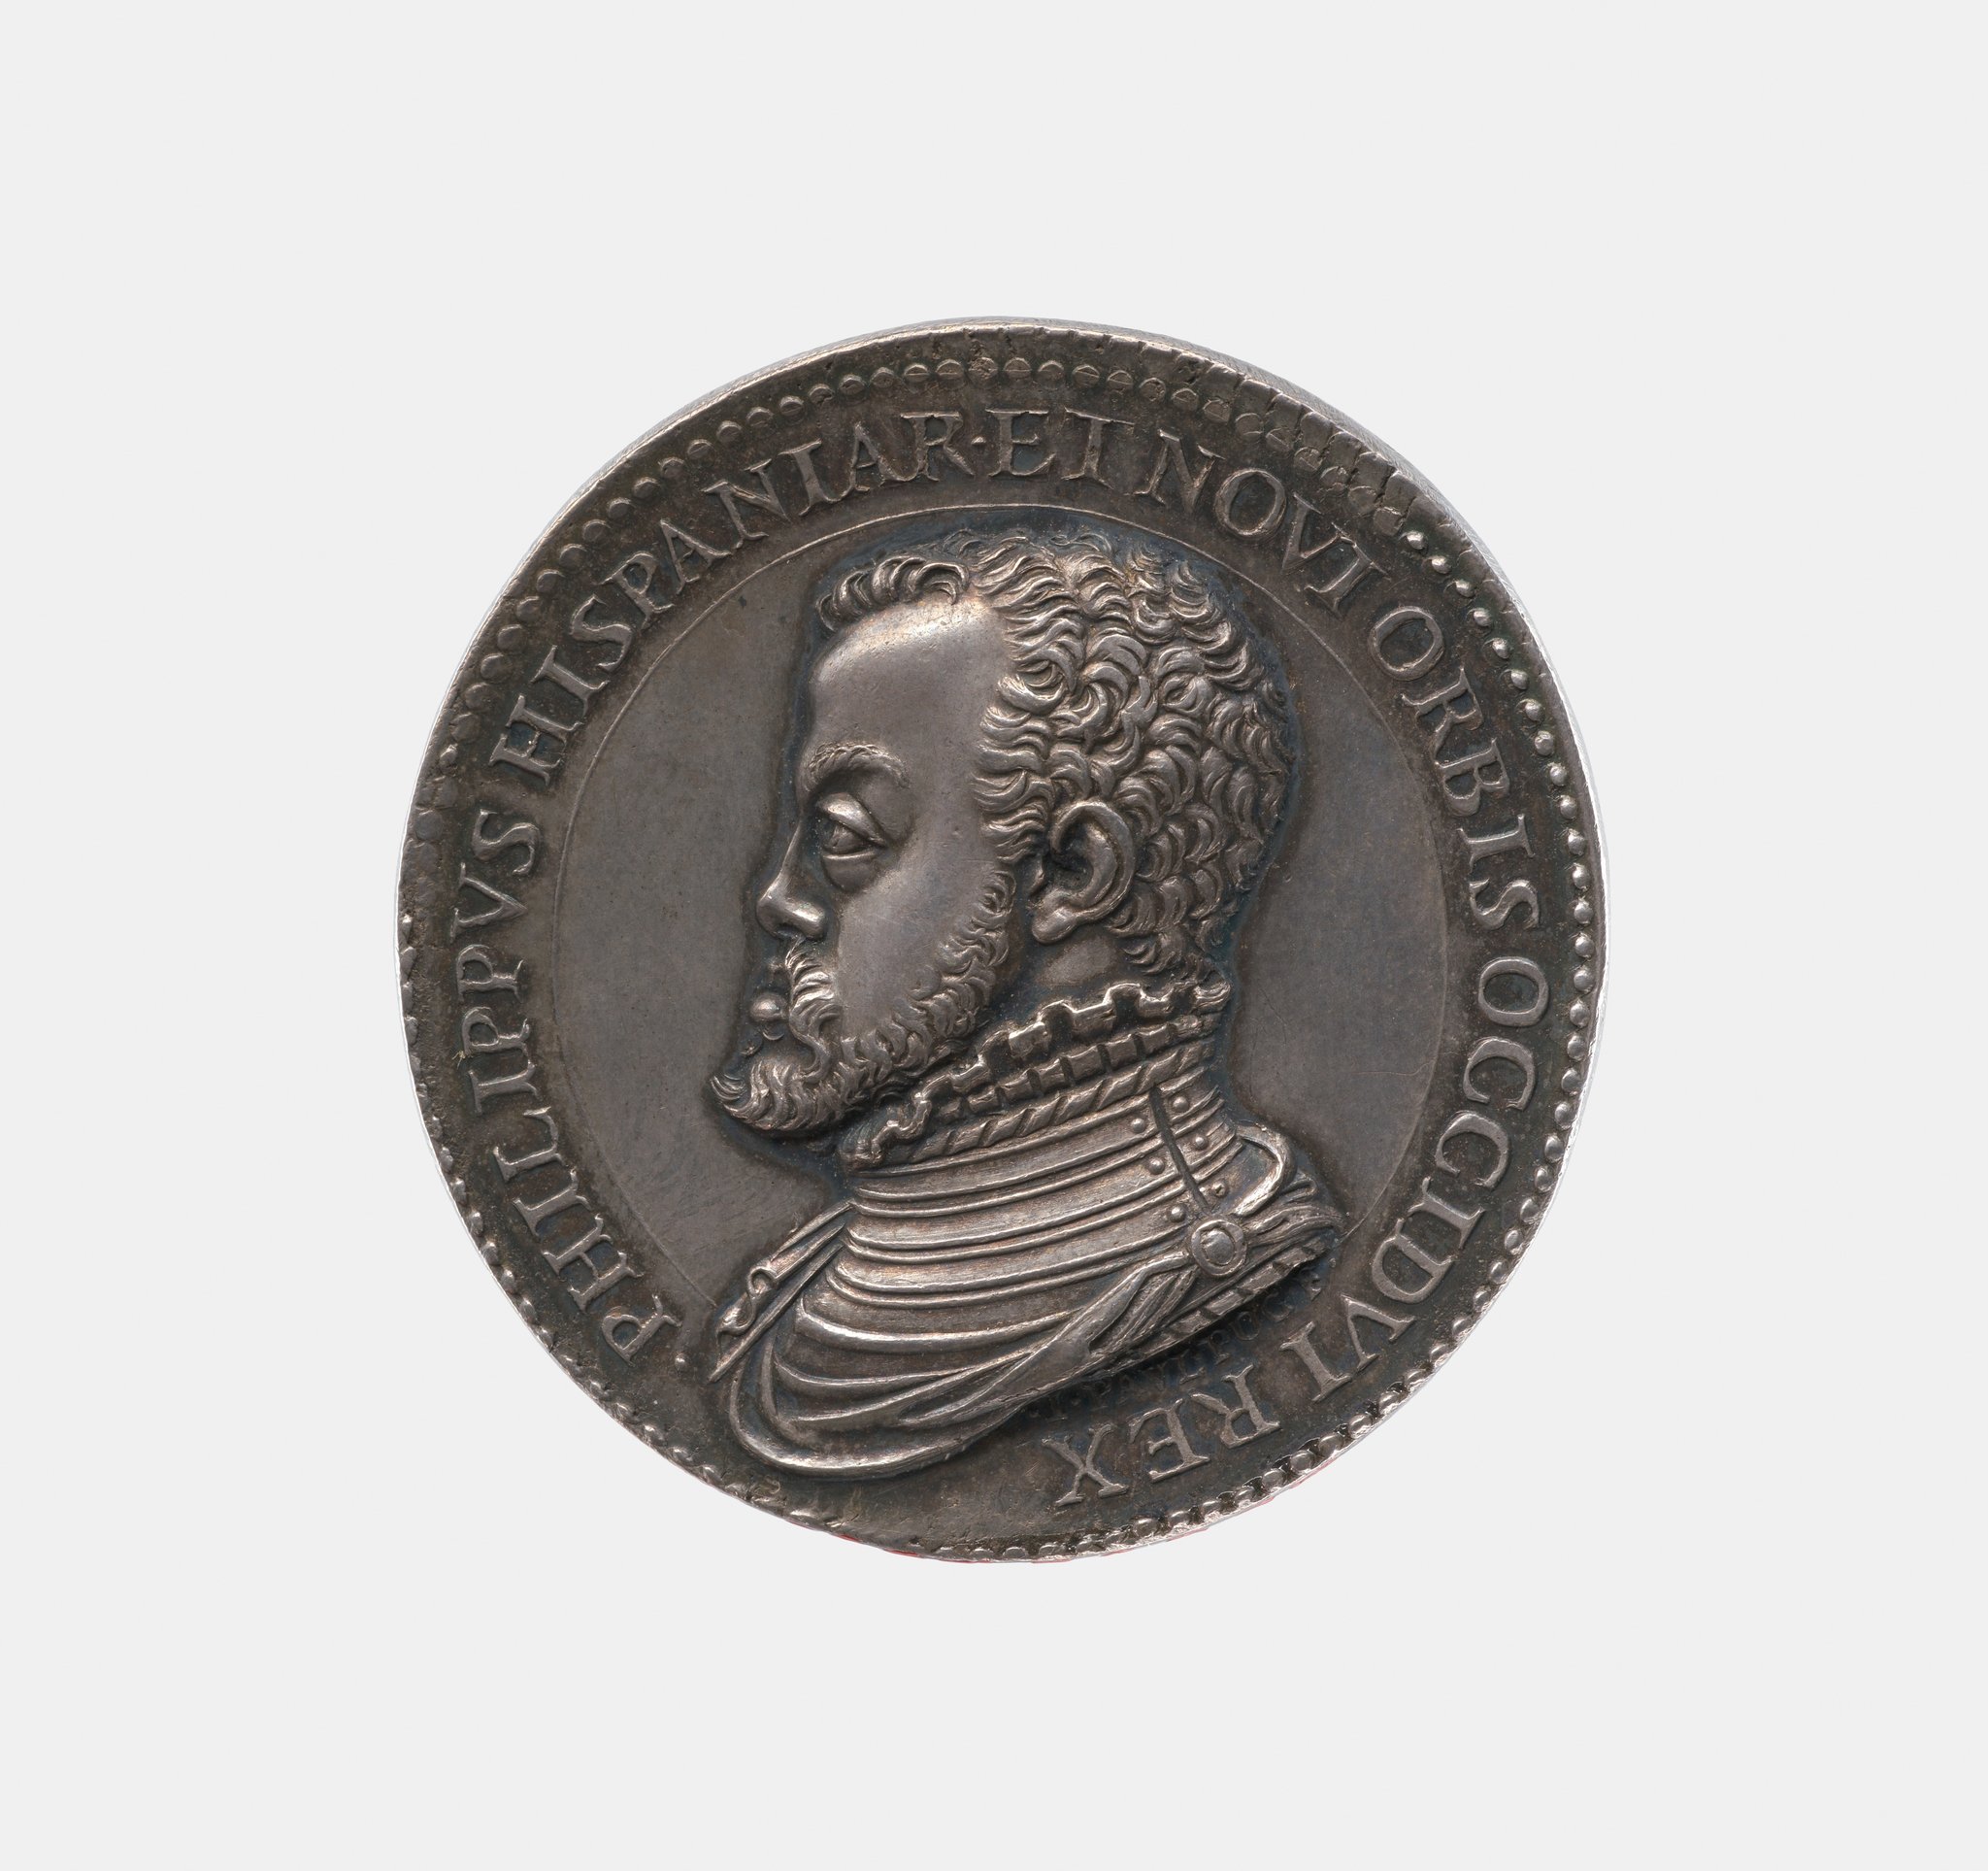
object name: medal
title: Philip II 1527-98, King of Spain 1556-98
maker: gianpaolo poggini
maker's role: artist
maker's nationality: italian, florence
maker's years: 1518-1582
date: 1559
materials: silver